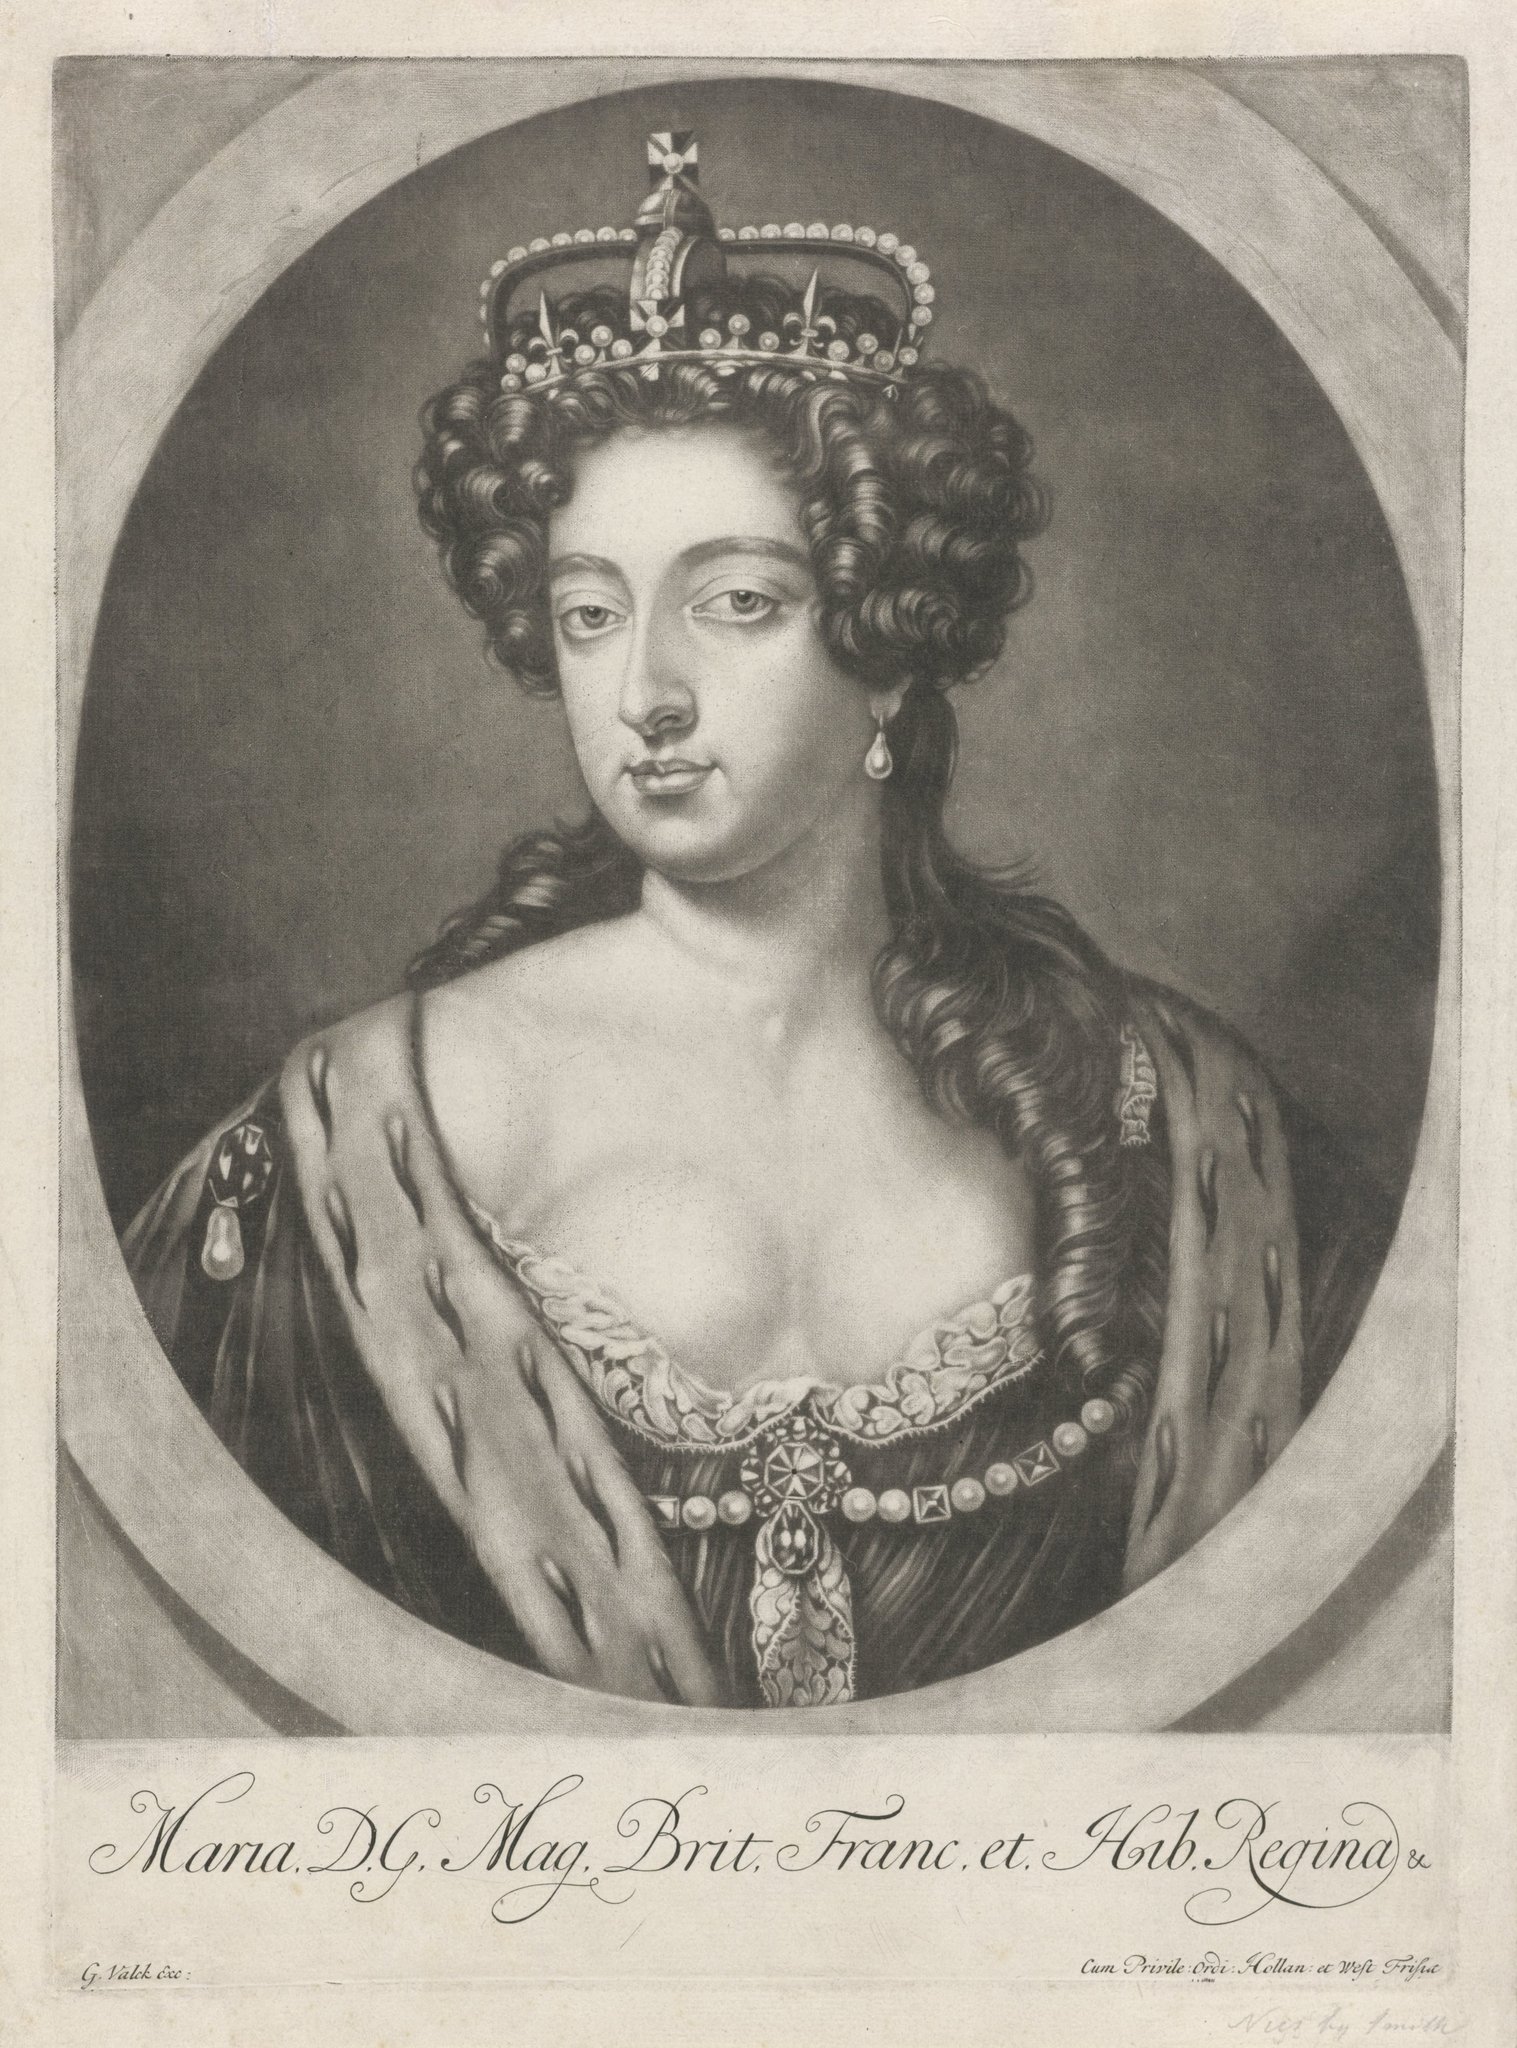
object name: print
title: Portret van Maria II Stuart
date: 1688-1726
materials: paper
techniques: mezzotint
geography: low countries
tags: london, maria ii stuart (koningin van engeland, schotland en ierland)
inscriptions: collector's mark: Lugt 2228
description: Portret van Maria II met een kroon in een ovaal. In de ondermarge haar naam en titels.